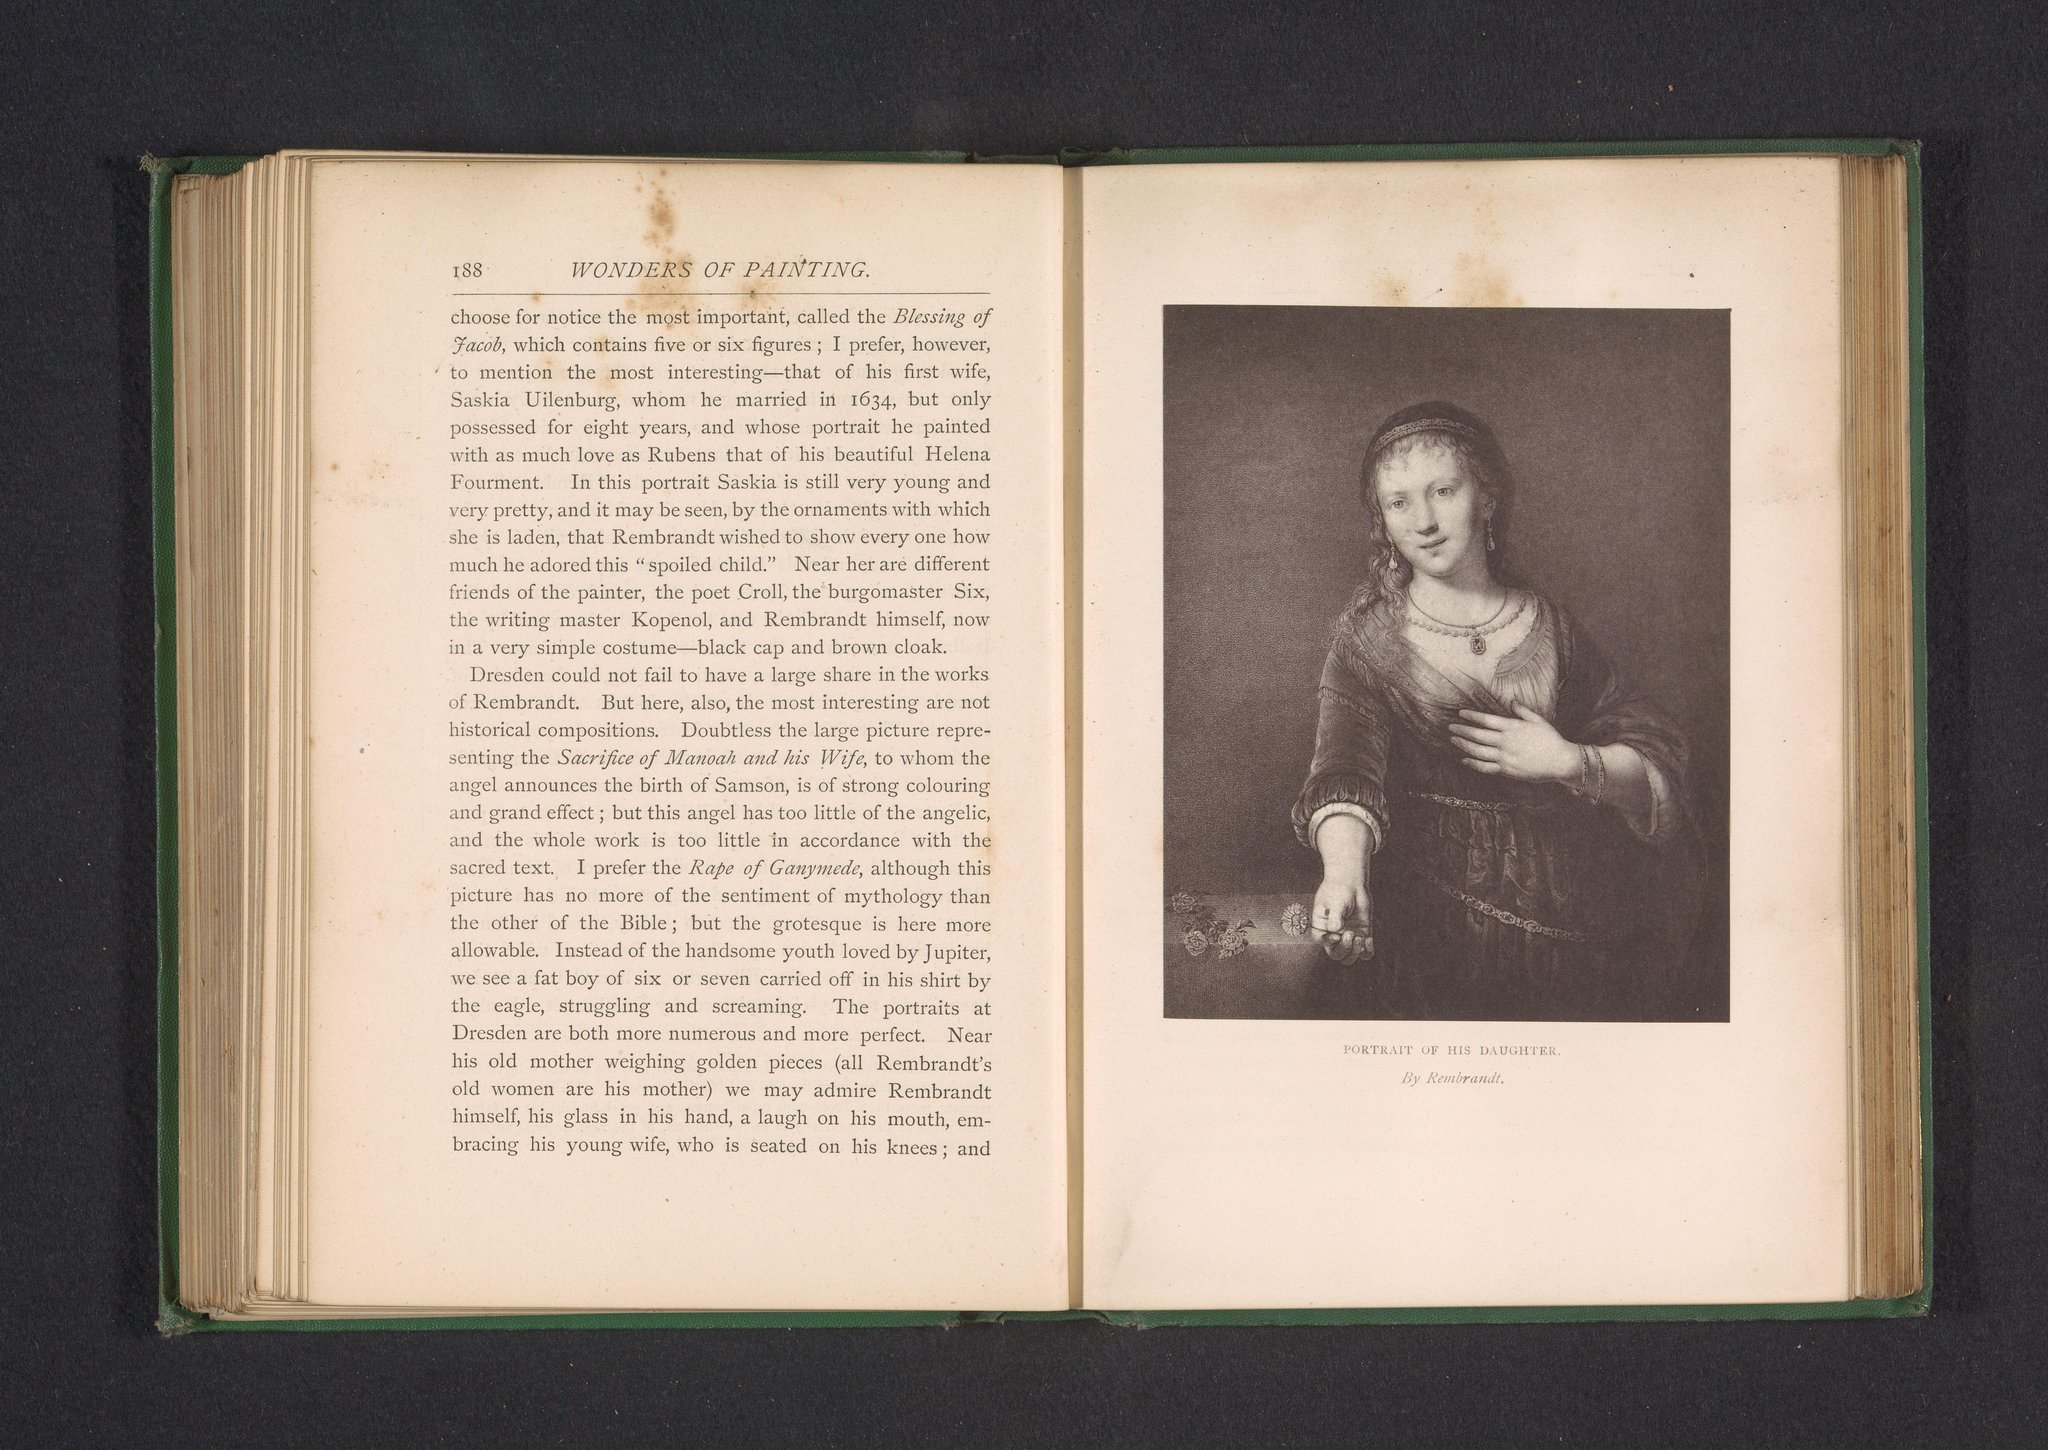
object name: reproduction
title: Fotoreproductie van een prent naar het portret van Saskia met een bloem door Rembrandt Harmensz. van Rijn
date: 1861-1871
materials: paper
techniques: woodburytype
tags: adult woman